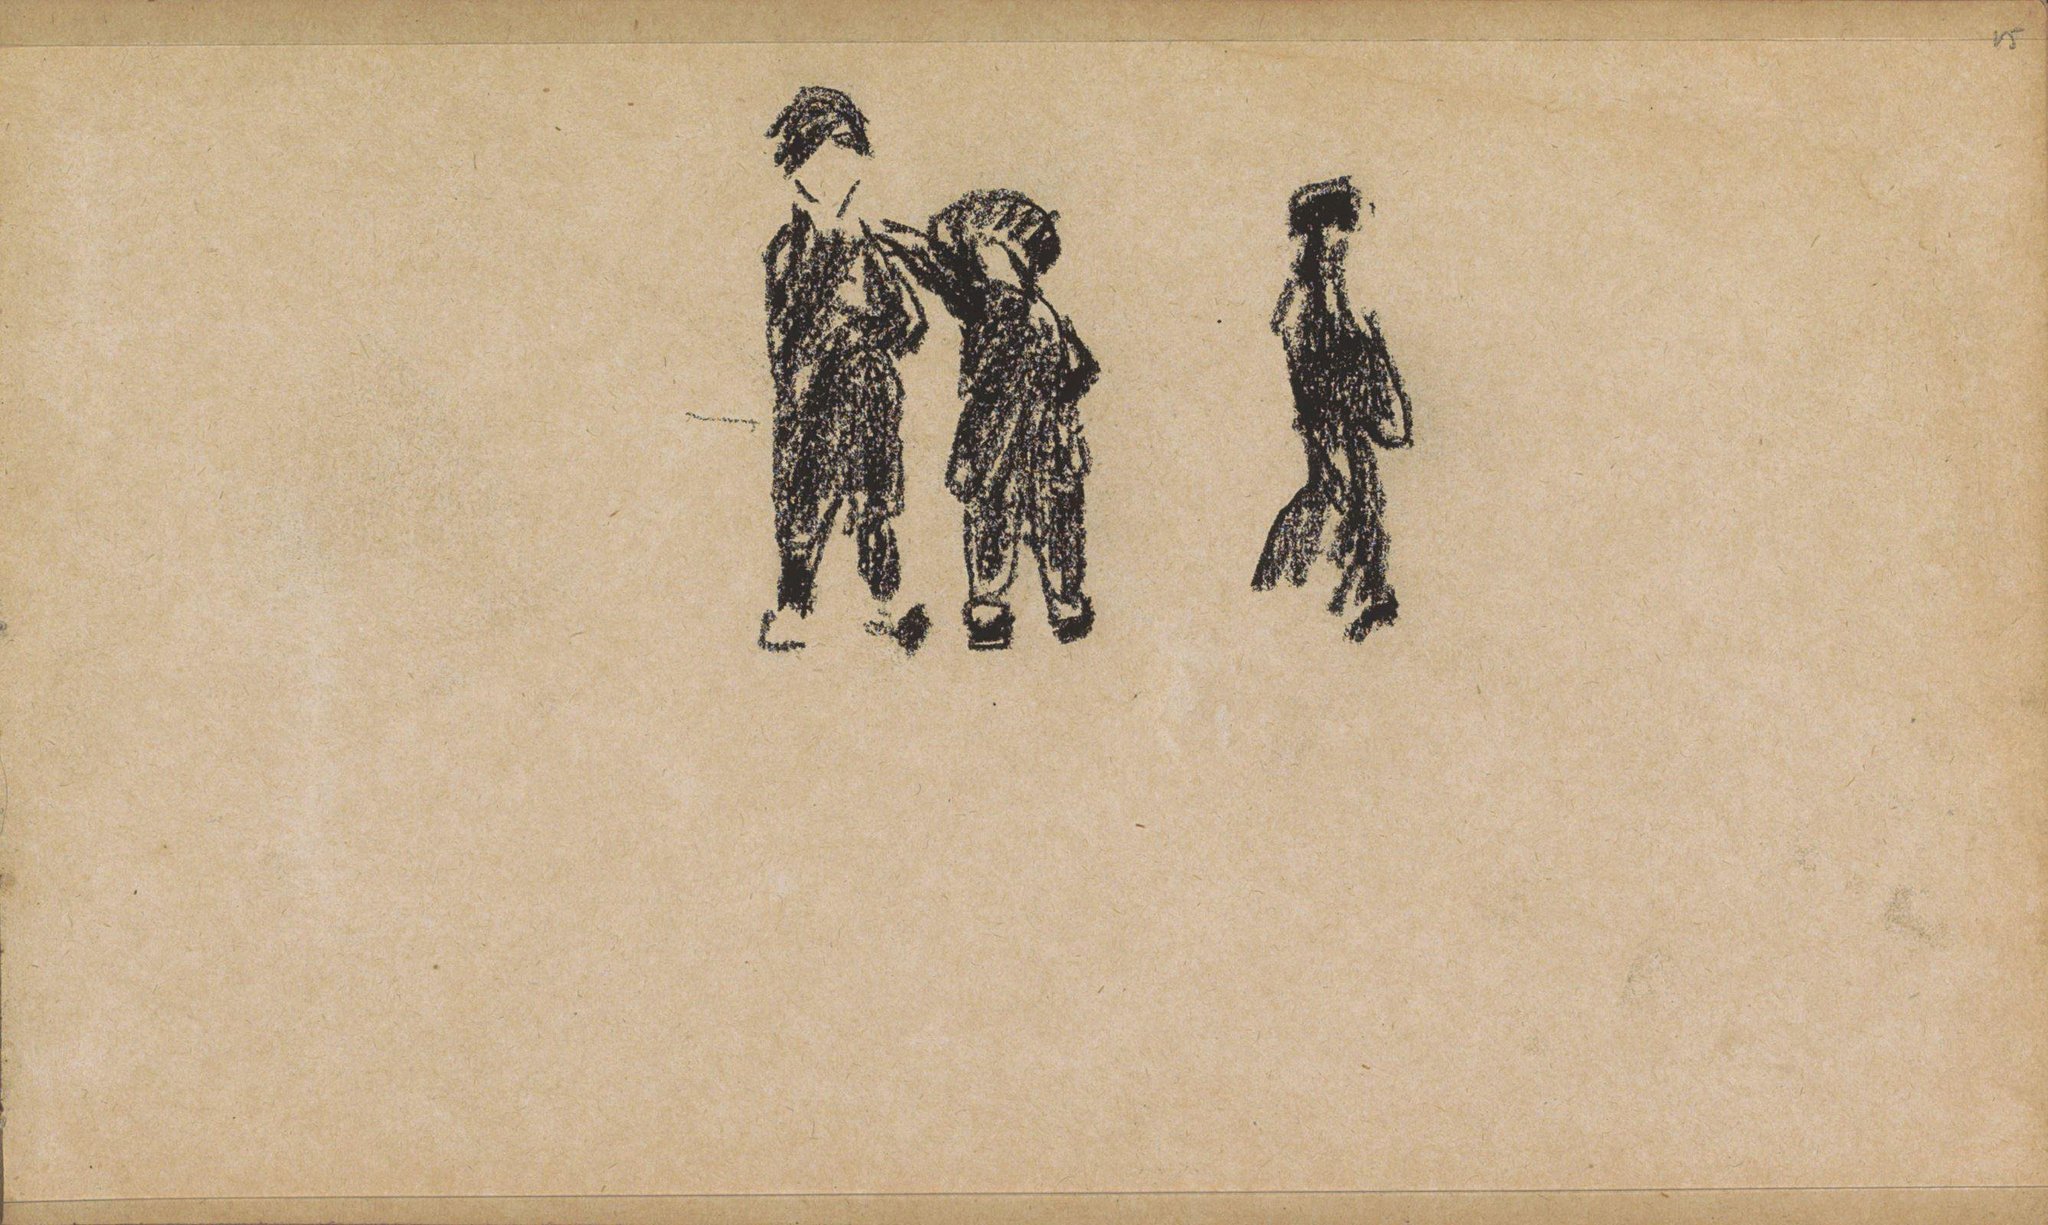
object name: sketchbook leaf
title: Drie figuurstudies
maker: willem witsen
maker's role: draughtsman, painter, print maker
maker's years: 1860-1923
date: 1888-1891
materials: chalk, paper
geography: amsterdam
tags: adult woman, child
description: Twee kinderen en mogelijk een vrouw. Pagina 15 uit een schetsboek met 27 bladen.